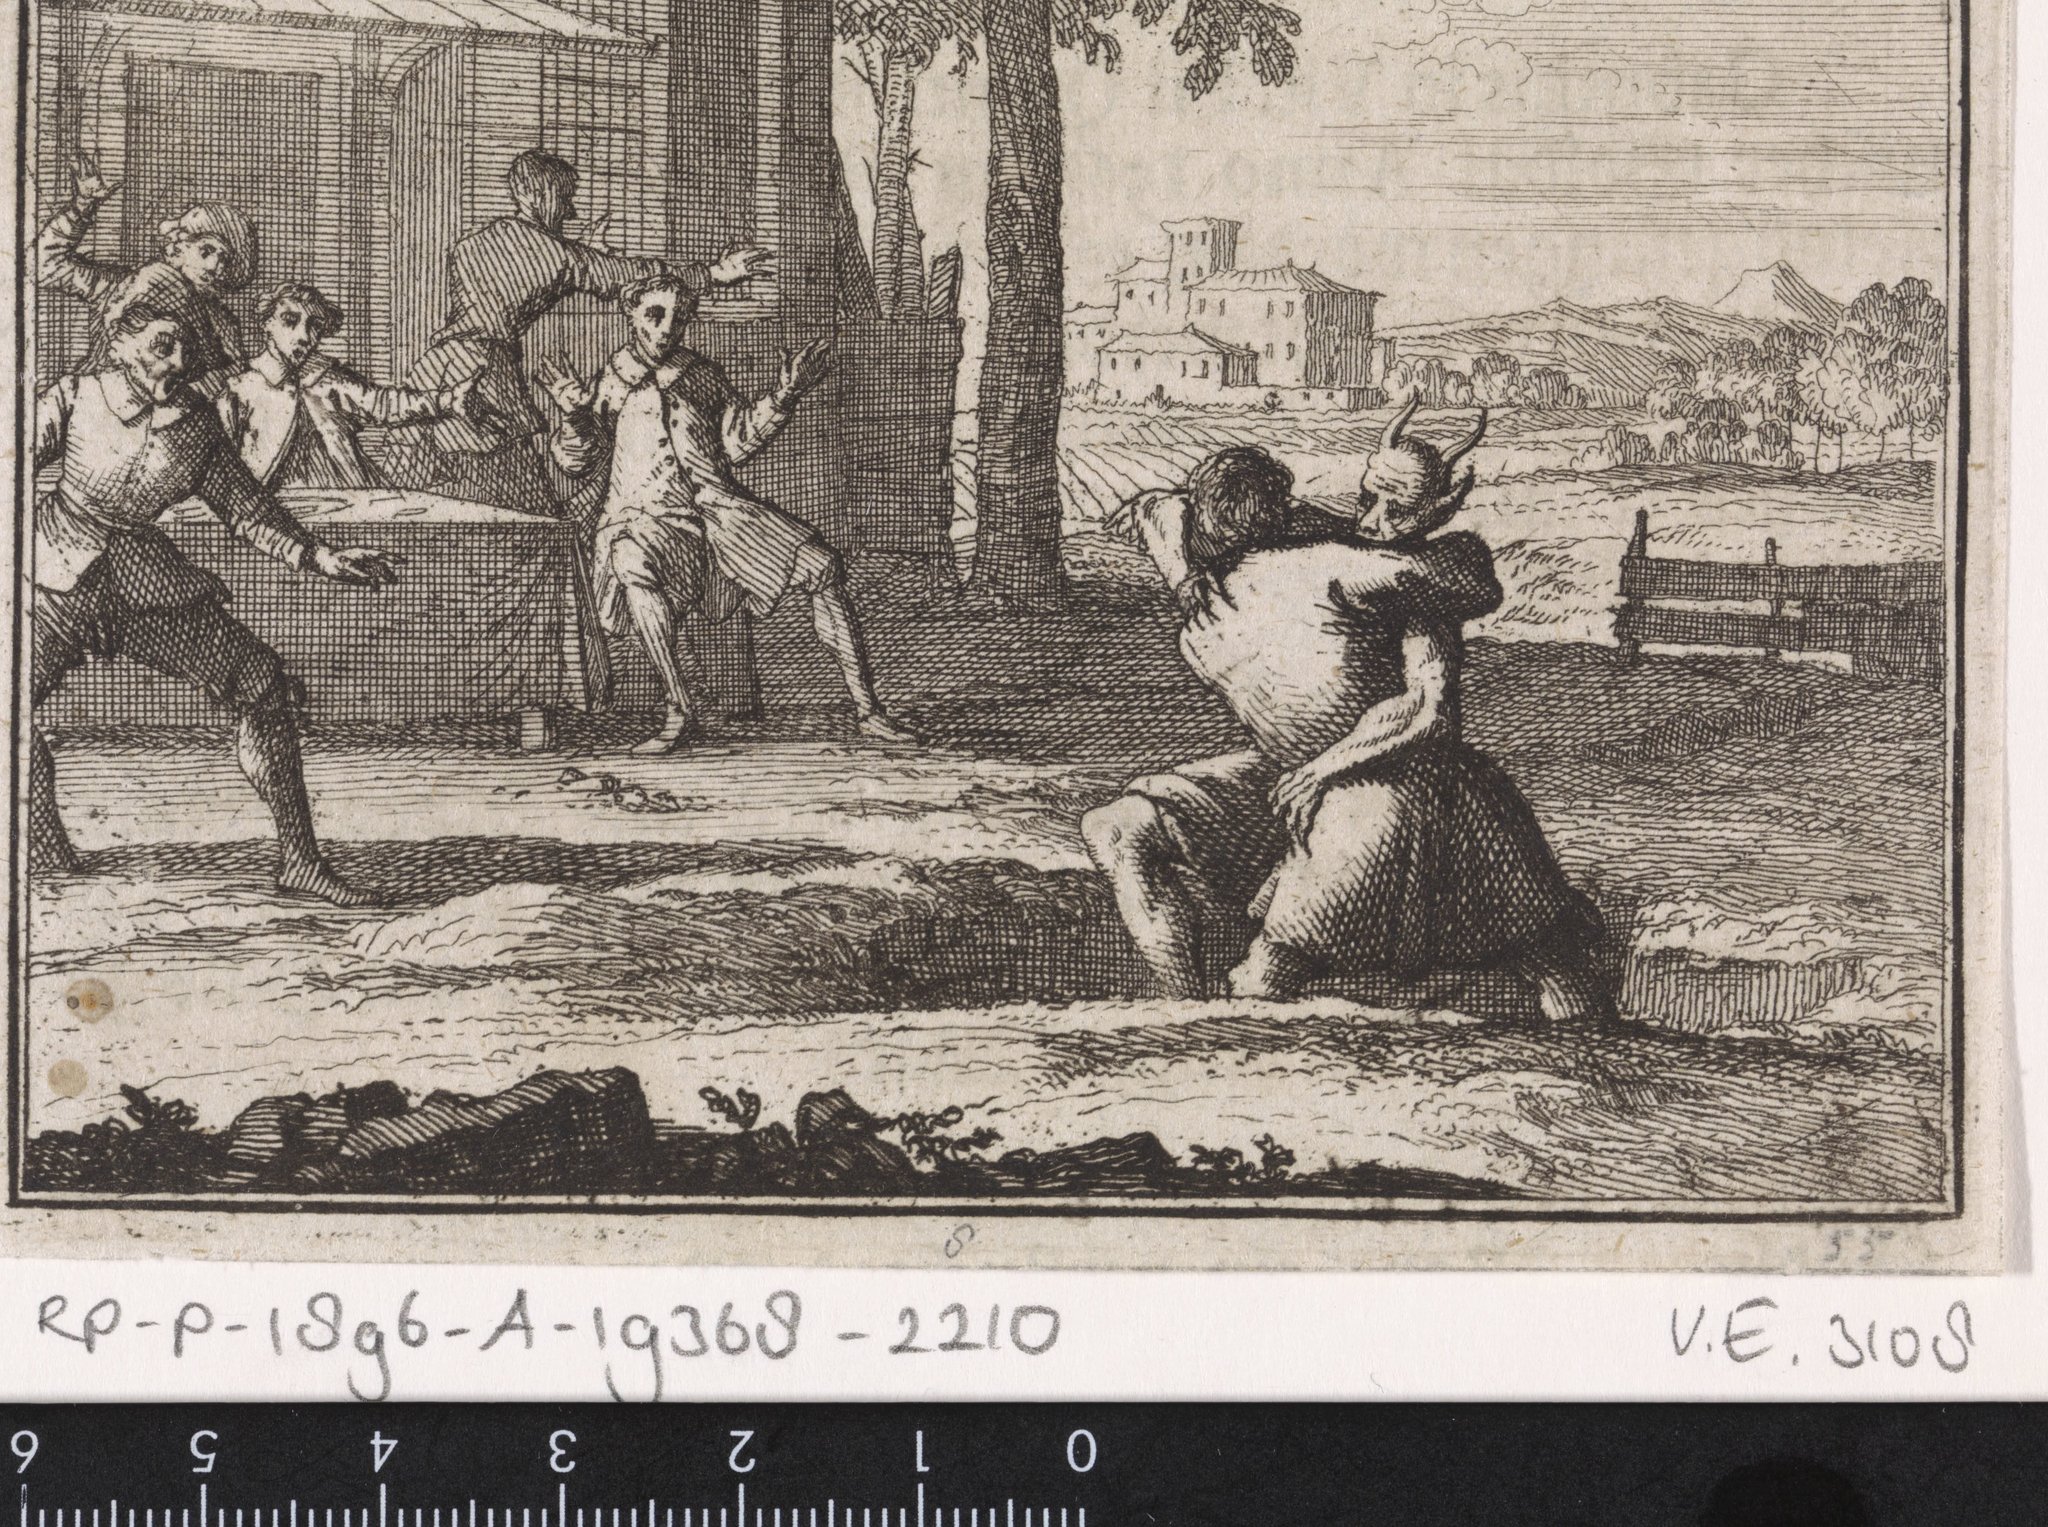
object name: book illustration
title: Du ein Christ ?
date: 1704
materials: paper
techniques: etching, letterpress printing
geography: nuremberg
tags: devil or demons attacking mortals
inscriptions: collector's mark: Lugt 2228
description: Illustratie uit: Abraham a Sancta Clara. Heilsames Gemisch Gemasch, das ist: Allerley seltsame und verwunderliche Geschichten (...). Neurenberg: Christoph Weigel, 1704, p. 55.